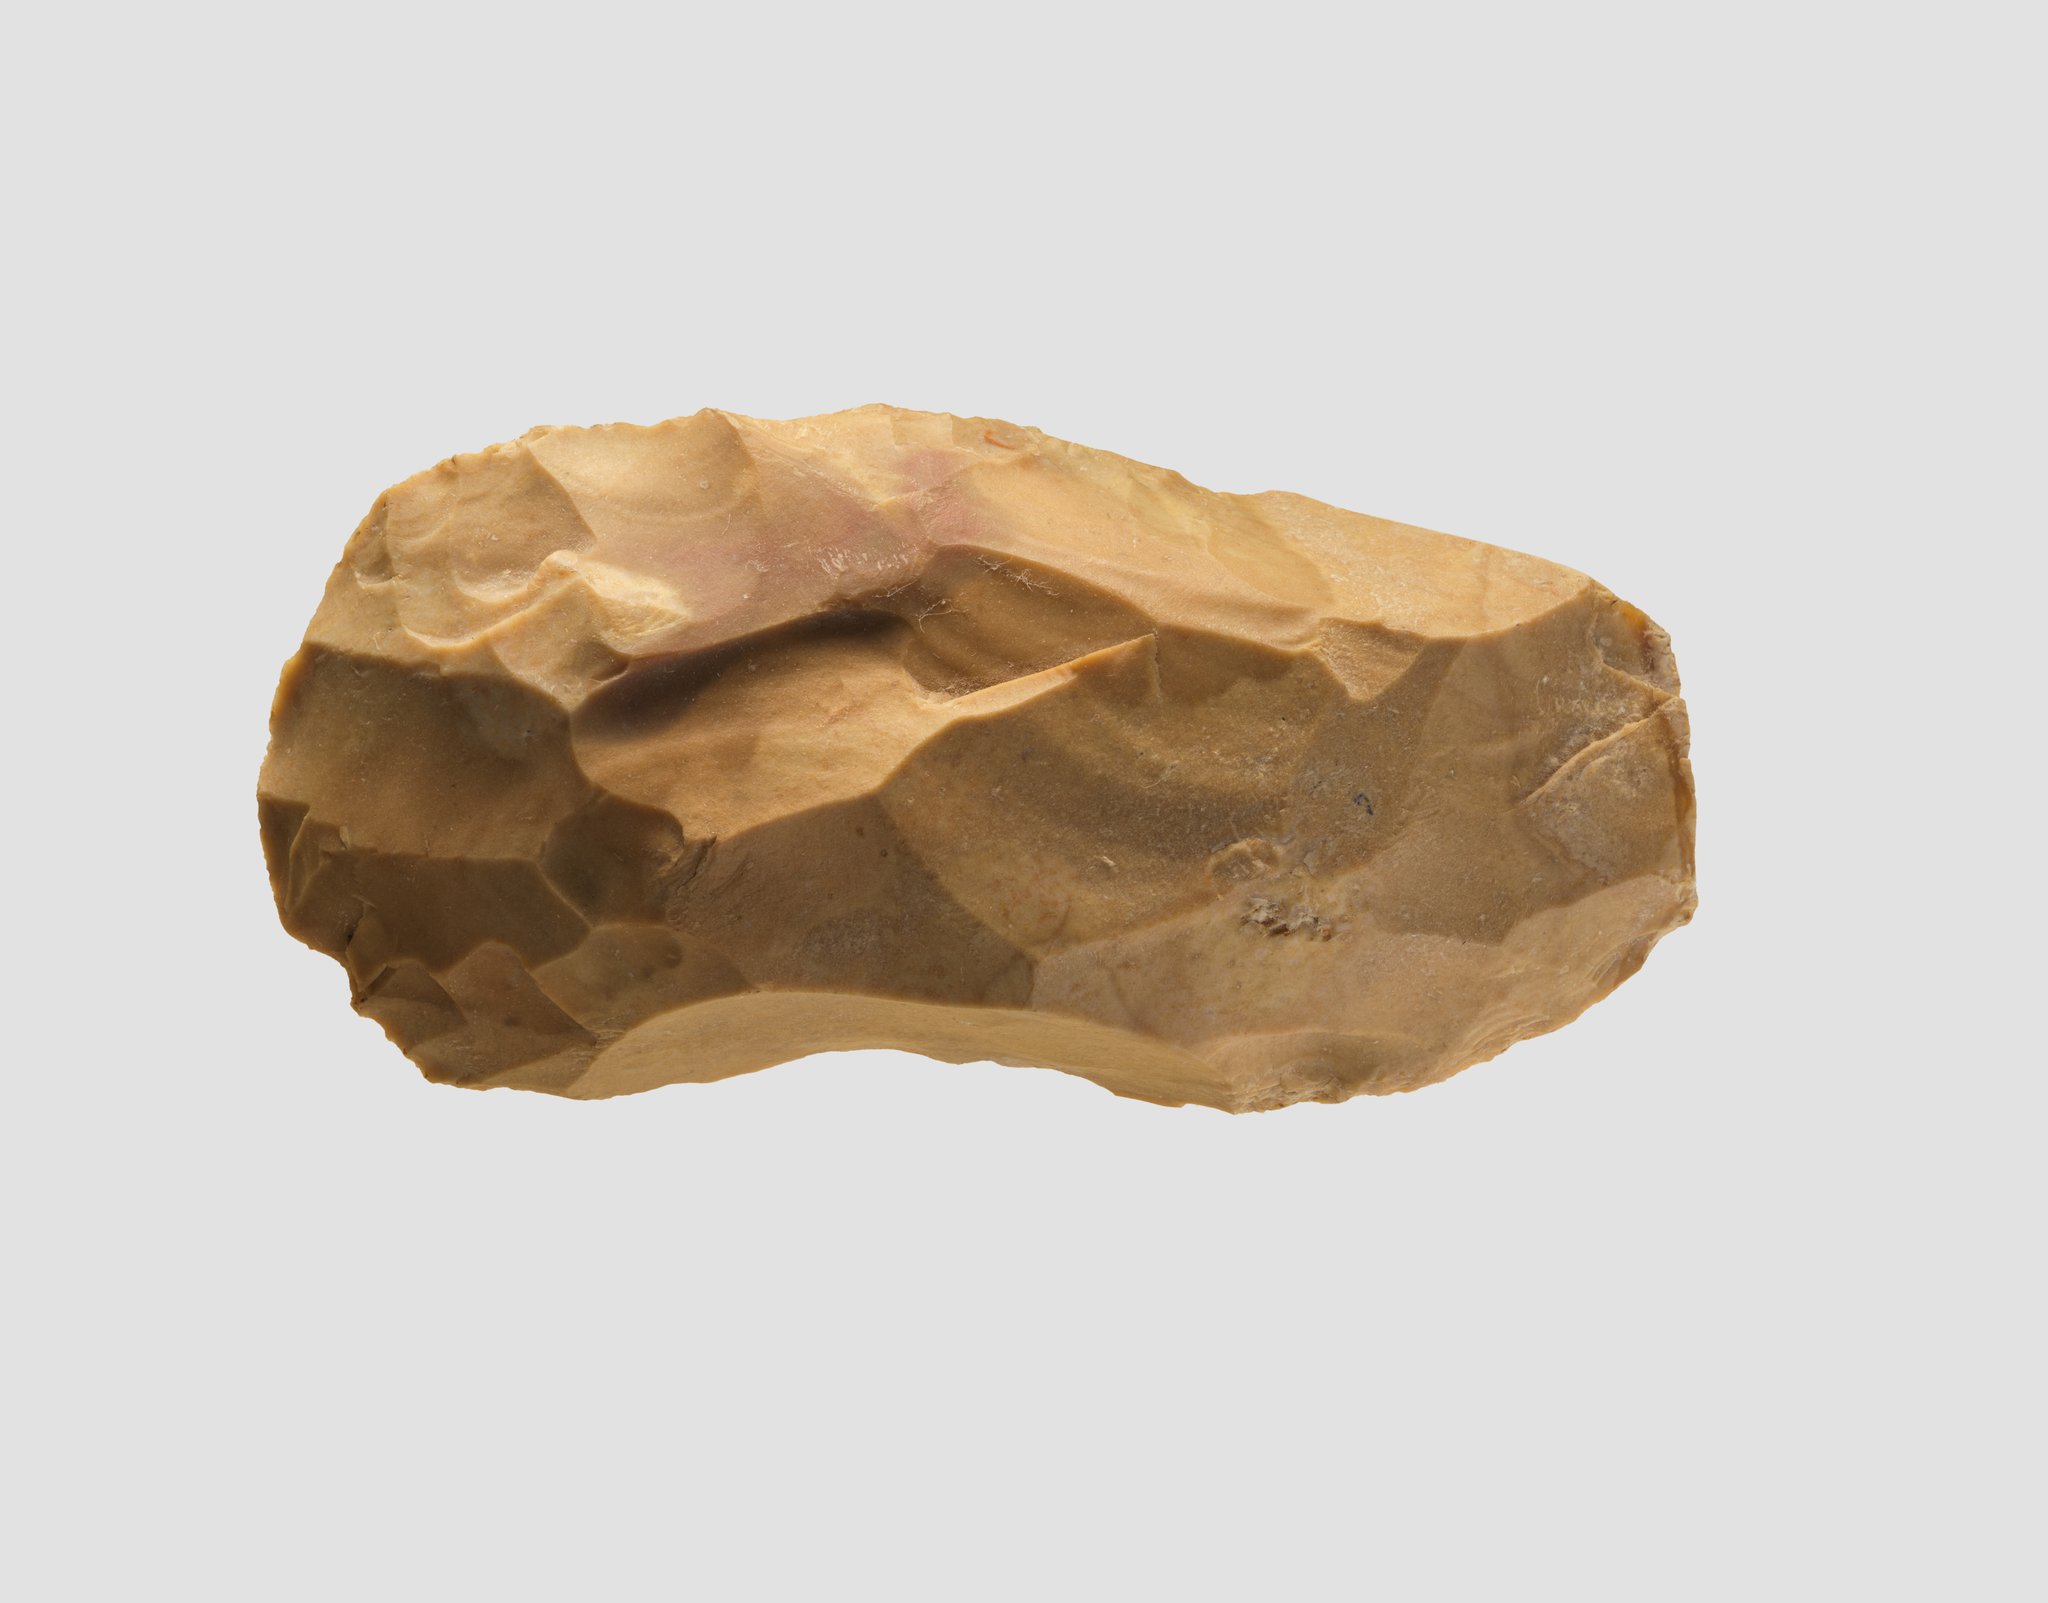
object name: chisel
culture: ghassulian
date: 4600-3600 BCE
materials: stone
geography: levant